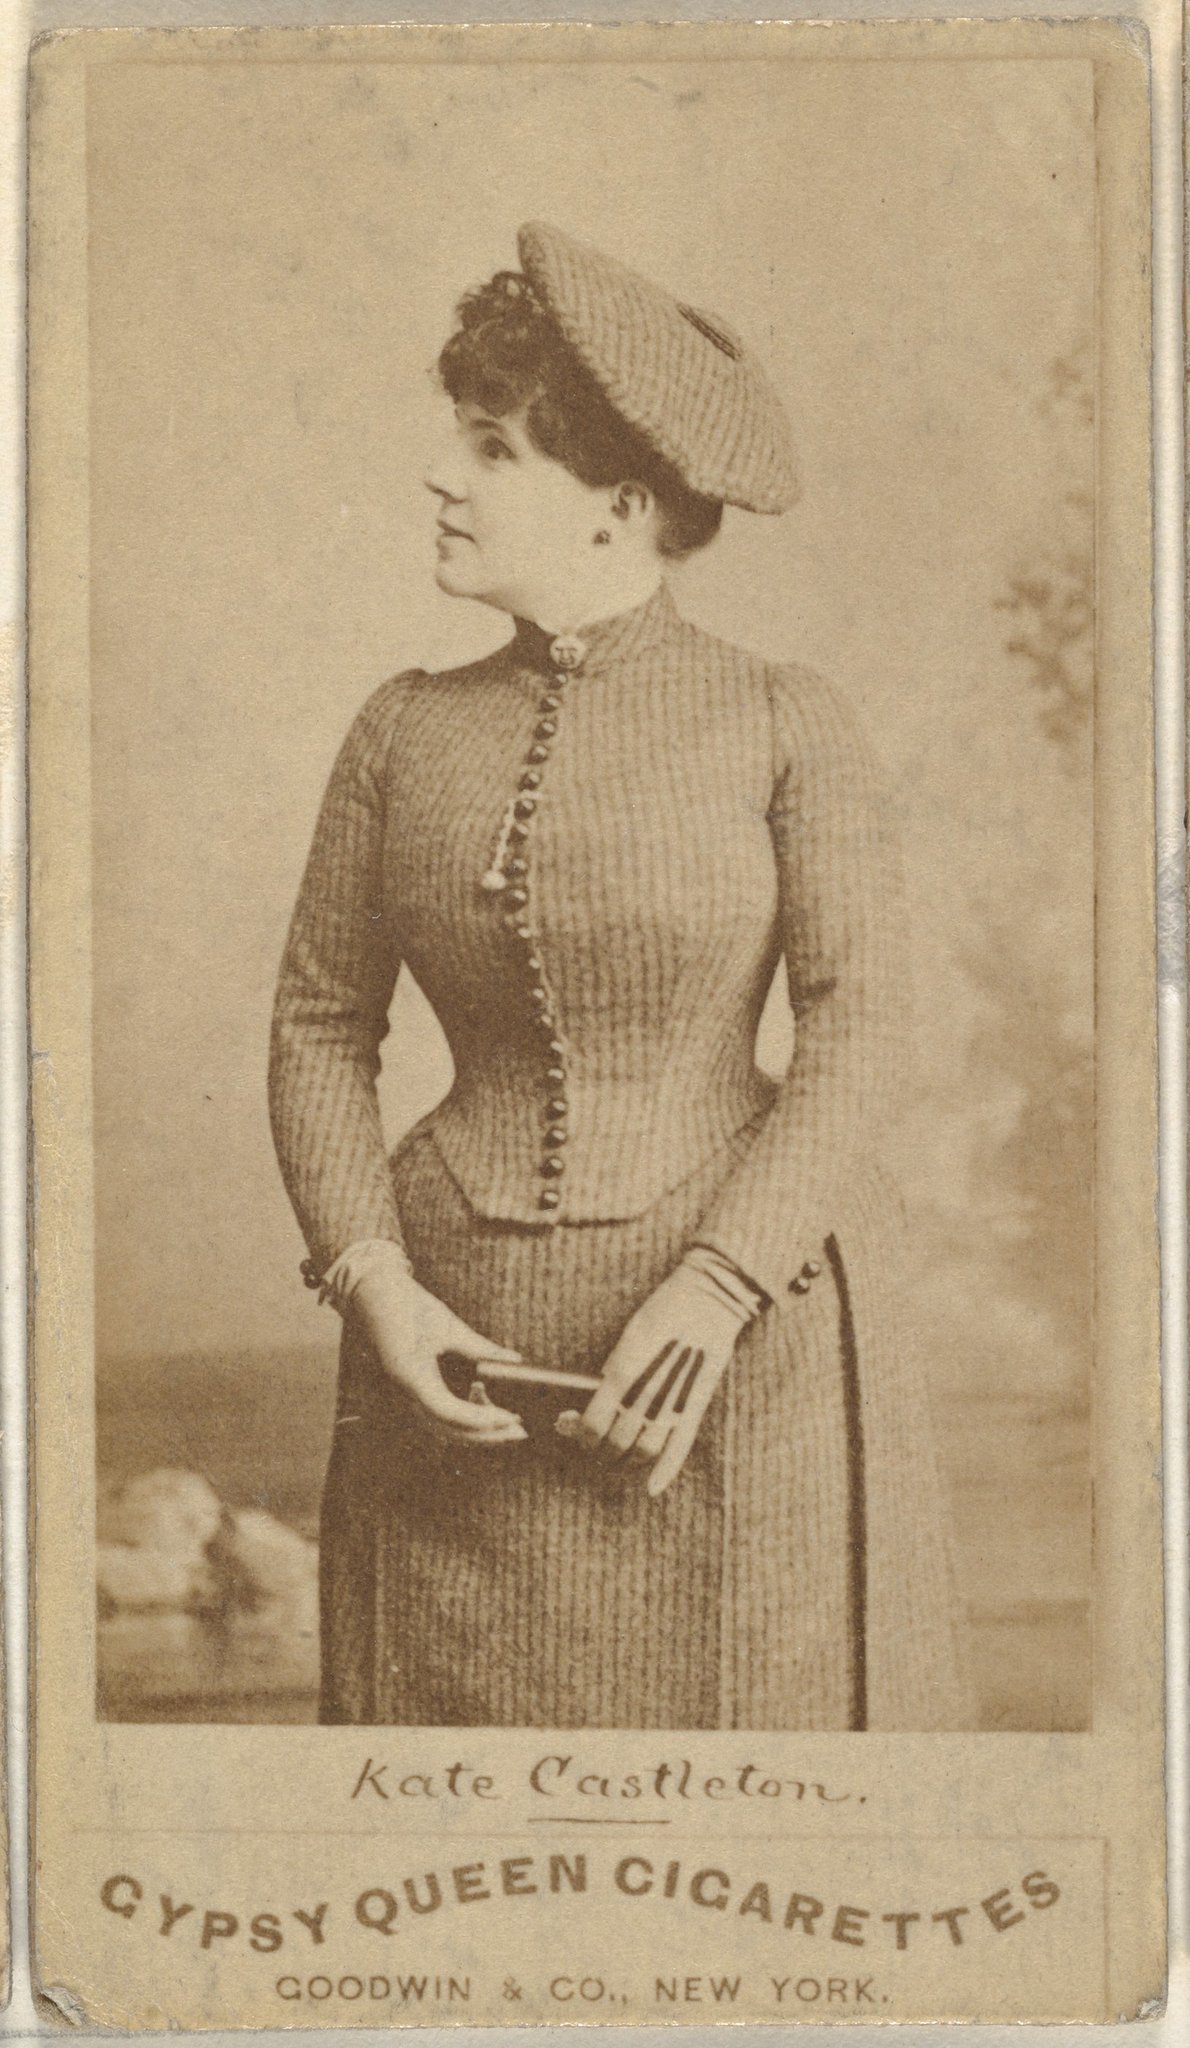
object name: photograph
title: Kate Castleton, from the Actors and Actresses series (N171) for Gypsy Queen Cigarettes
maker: goodwin & company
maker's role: publisher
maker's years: 1850-1950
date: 1886-1890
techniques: albumen silver print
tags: profiles,women,actresses